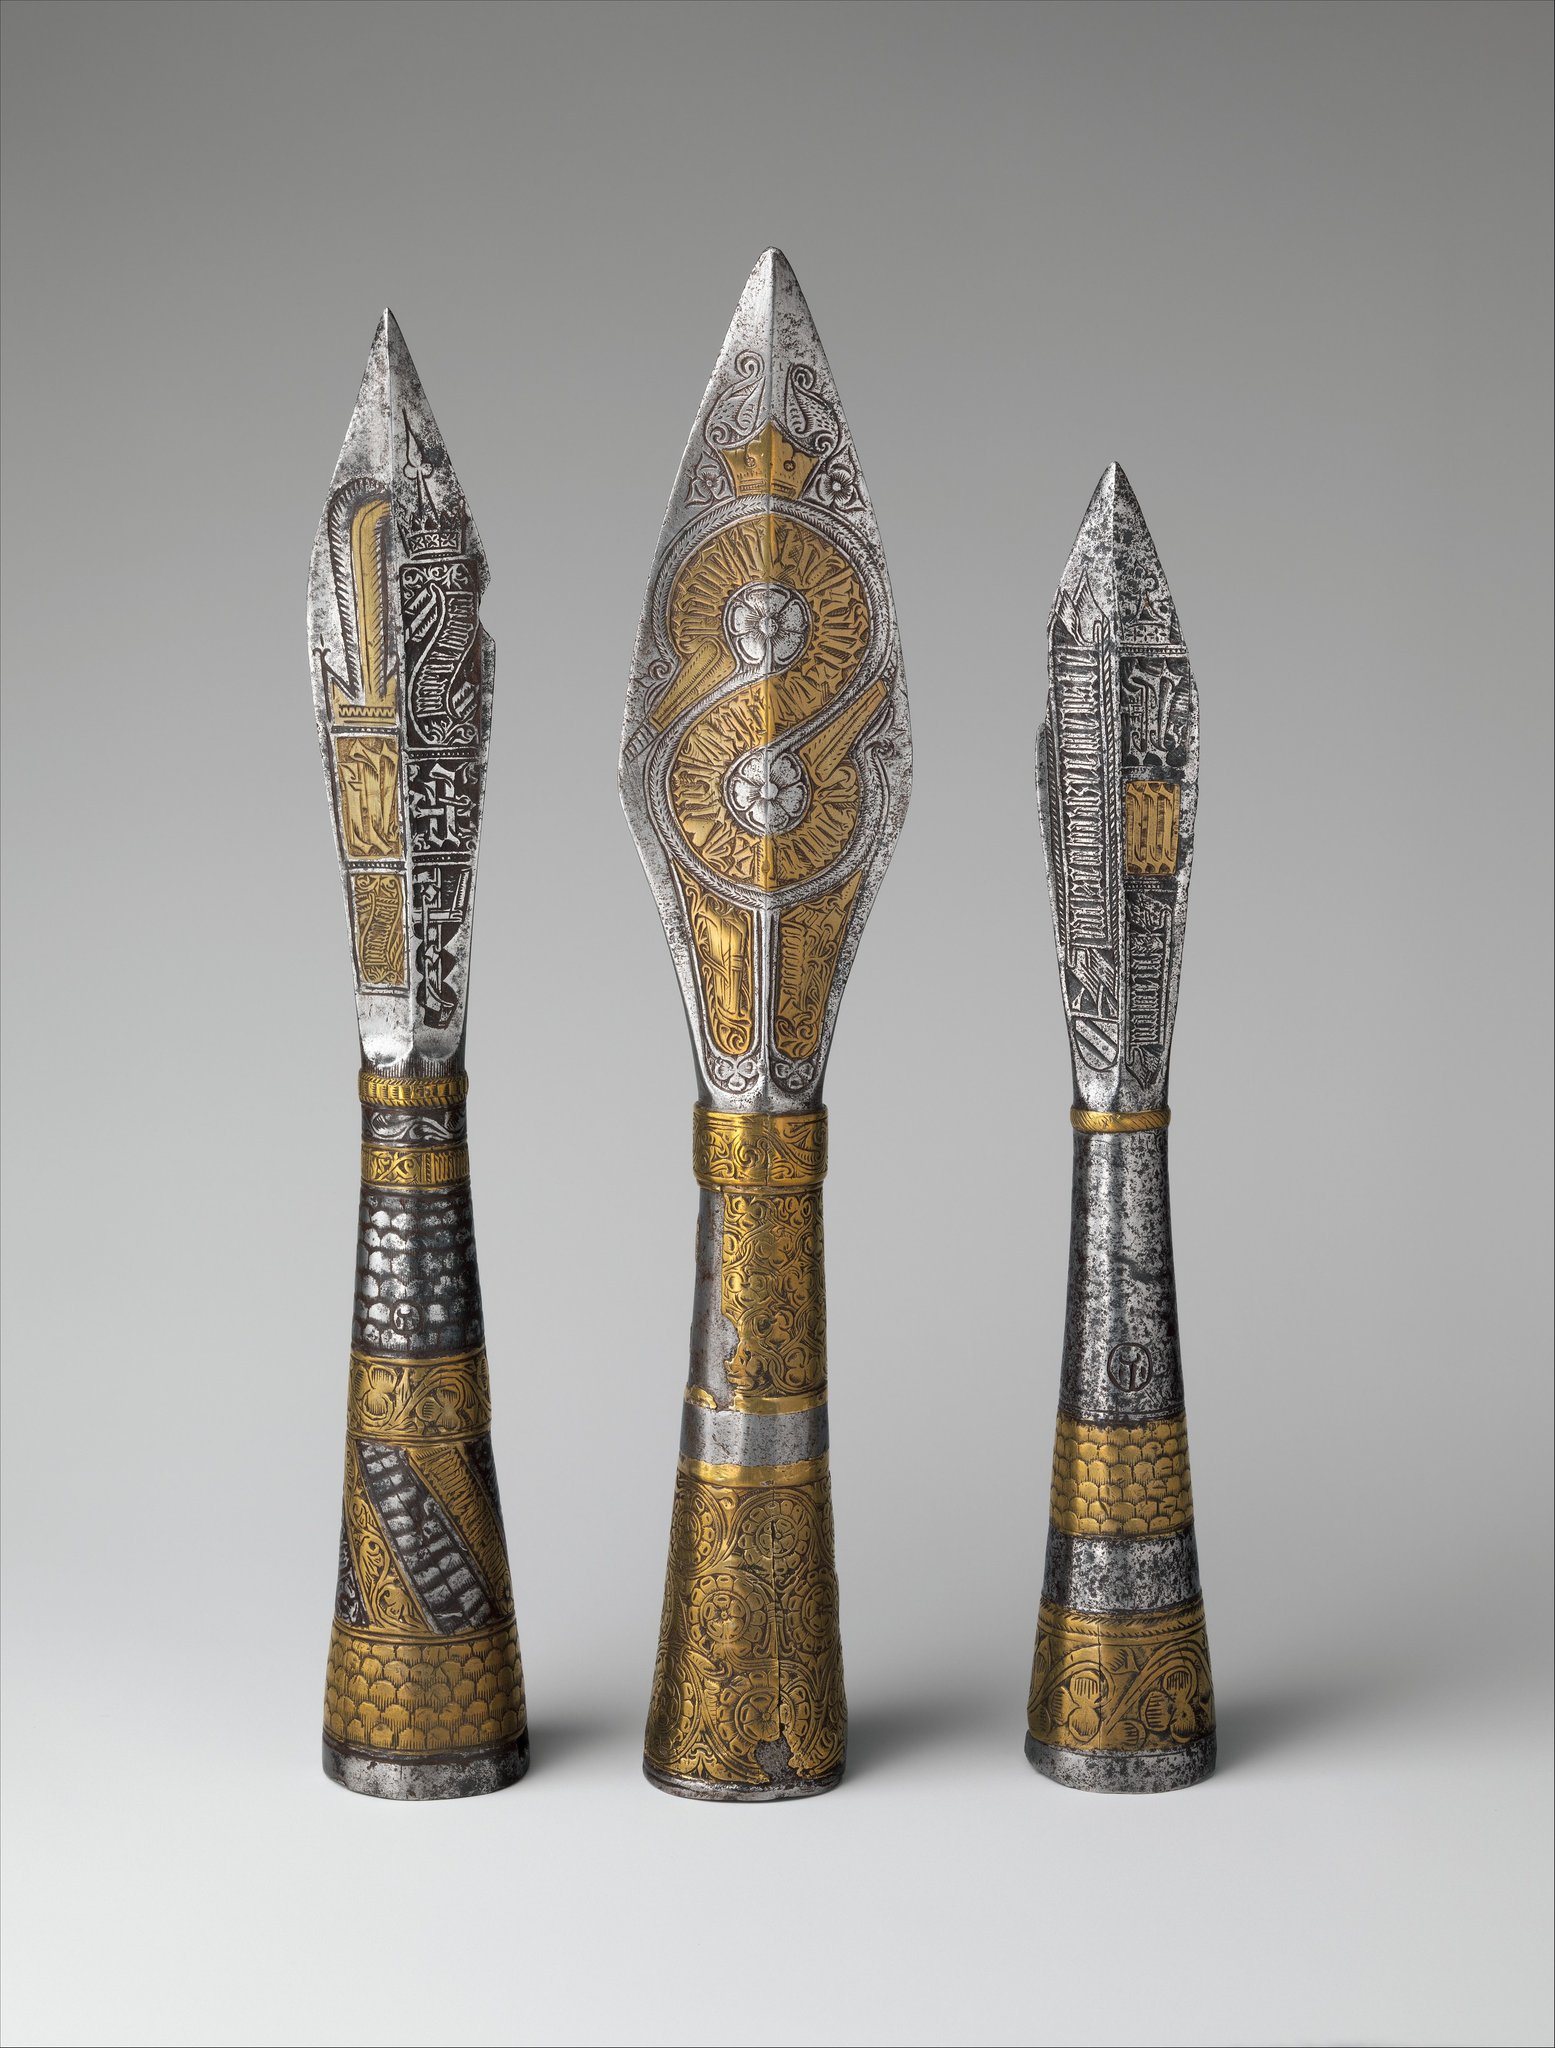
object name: ceremonial arrowhead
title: Three Ceremonial Arrowheads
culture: bohemian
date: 1437-1439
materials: copper alloy, steel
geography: czech republic